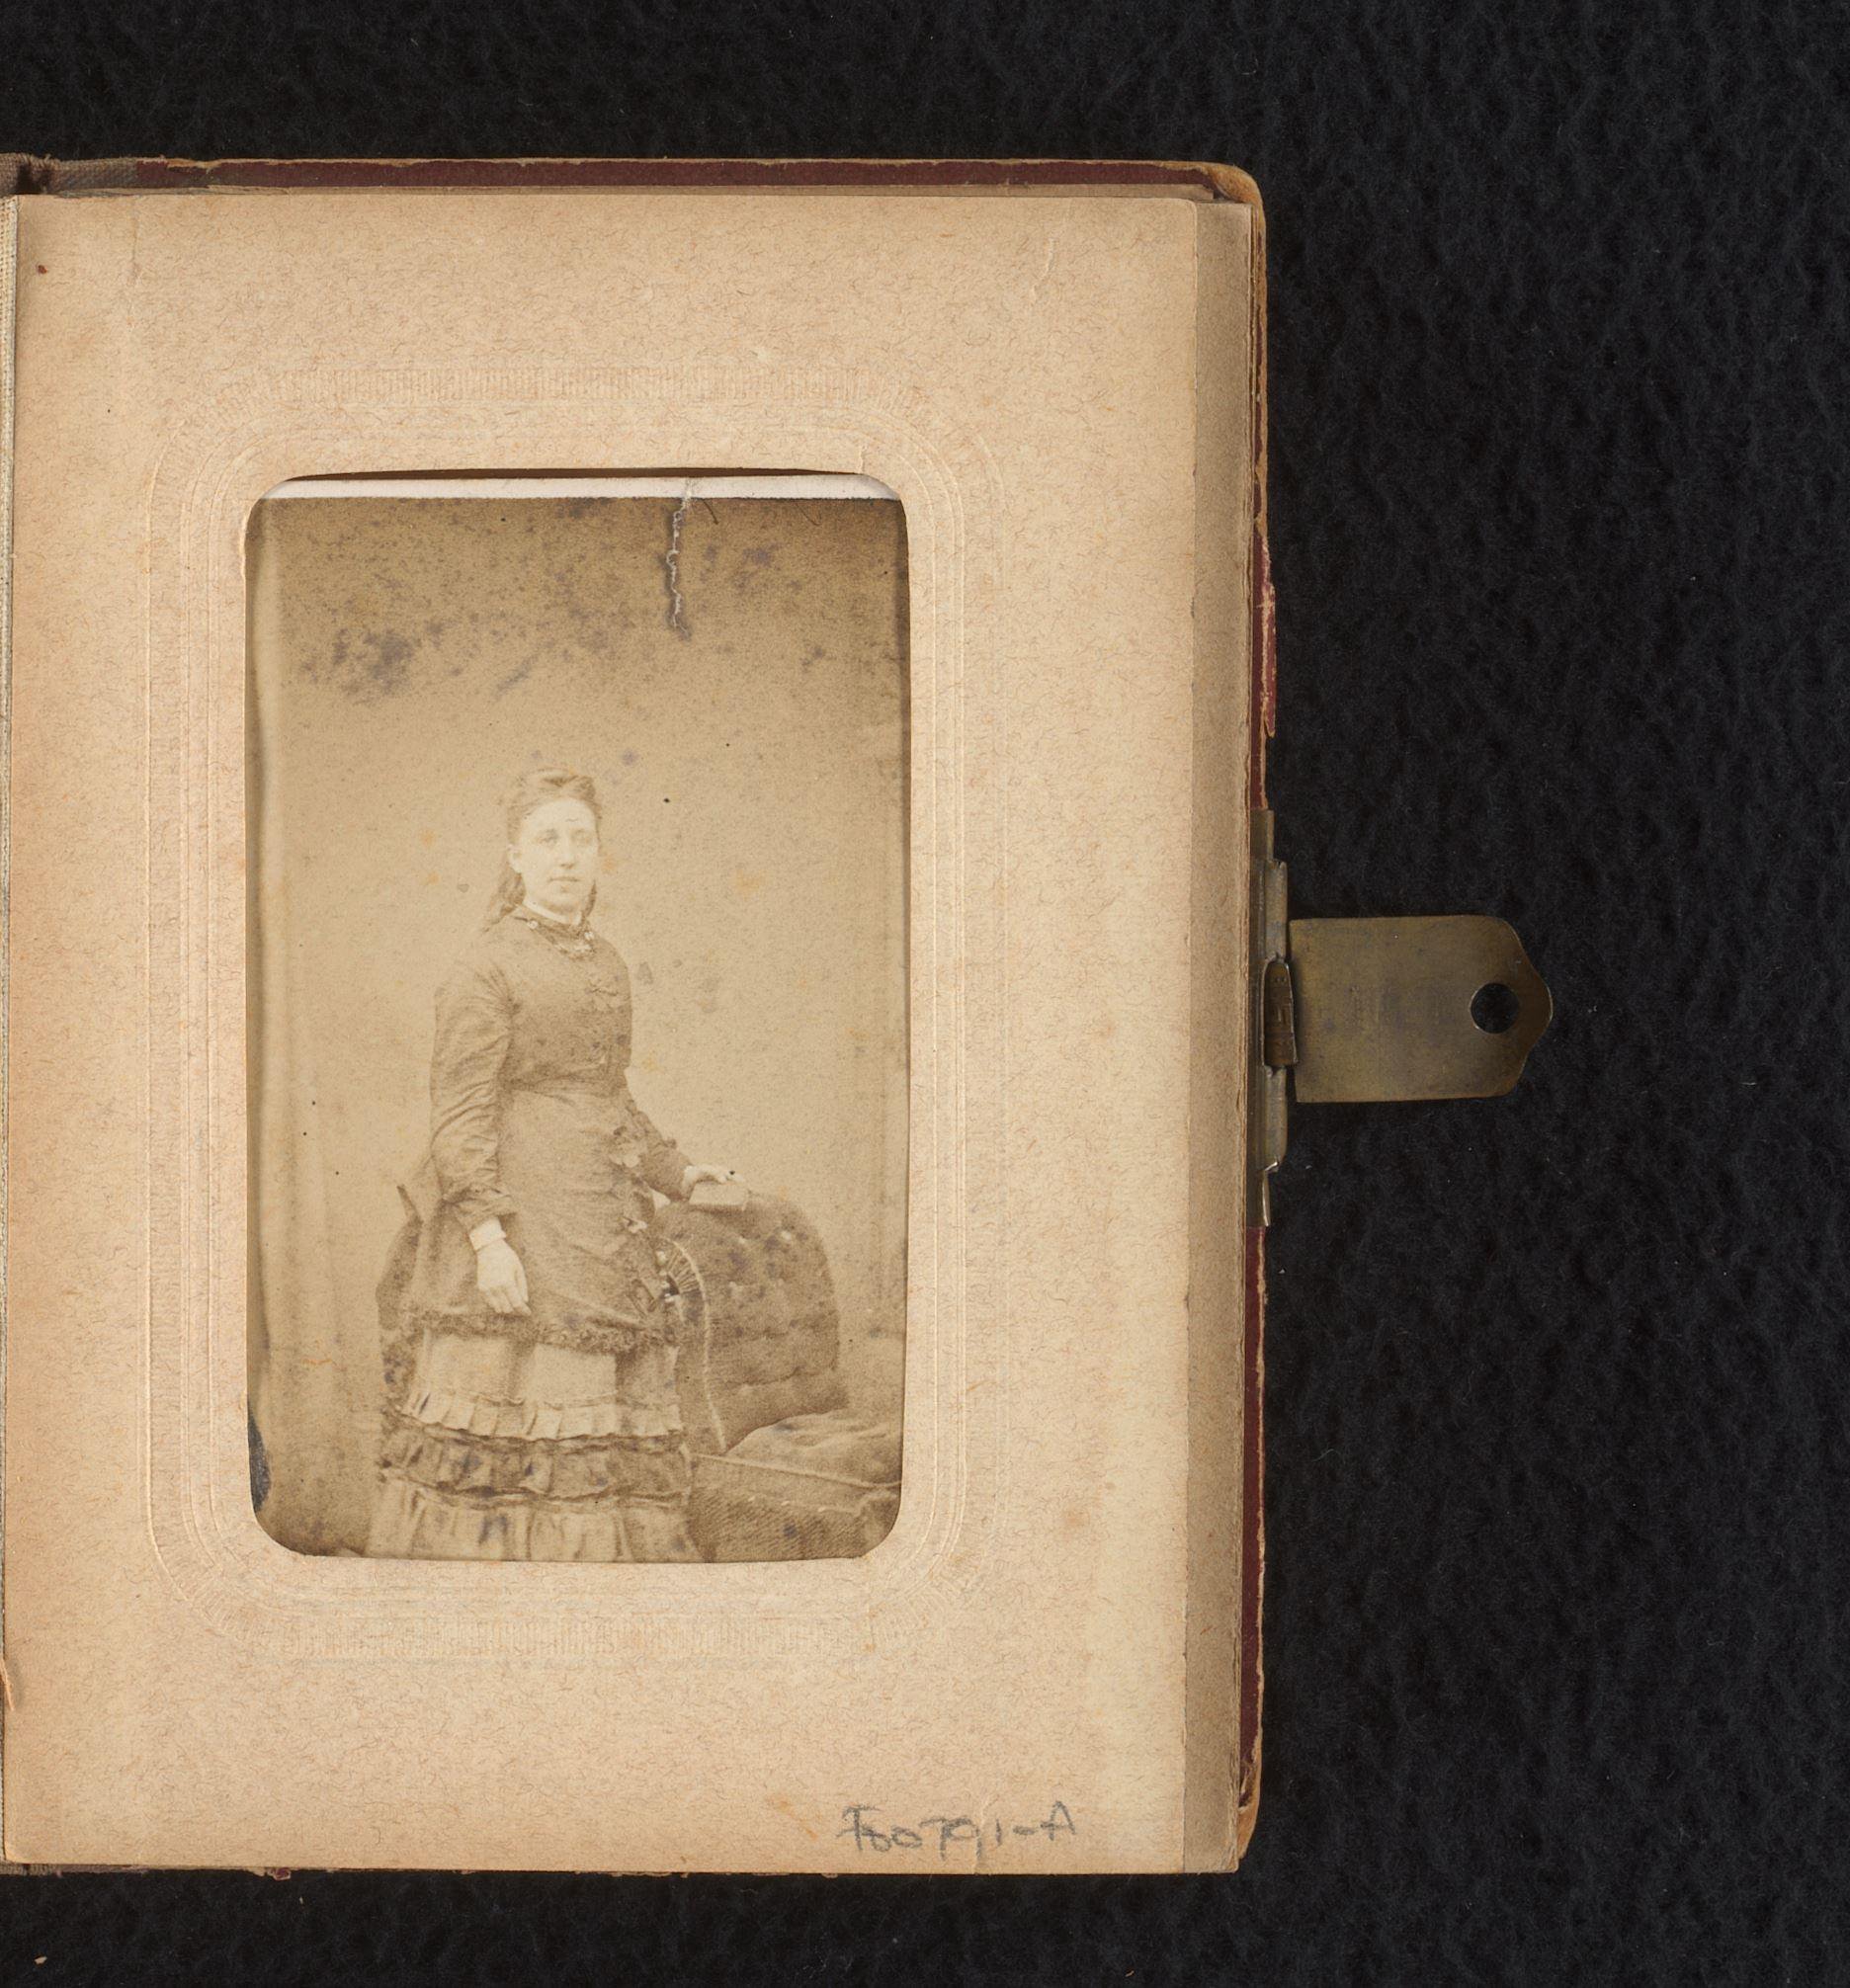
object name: photograph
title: Portret van een staande vrouw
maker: william hobbs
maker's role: fotograaf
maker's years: 1848-1916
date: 1860-1885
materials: cardboard, photographic support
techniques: photography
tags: historical persons, standing figure - aa - female human figure, chair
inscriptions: number: ‘9783’, inscription: ‘W.M. Hobbs/ Phoenix photographic studio/ 81, High St. Whitechapel. E./ (...)’